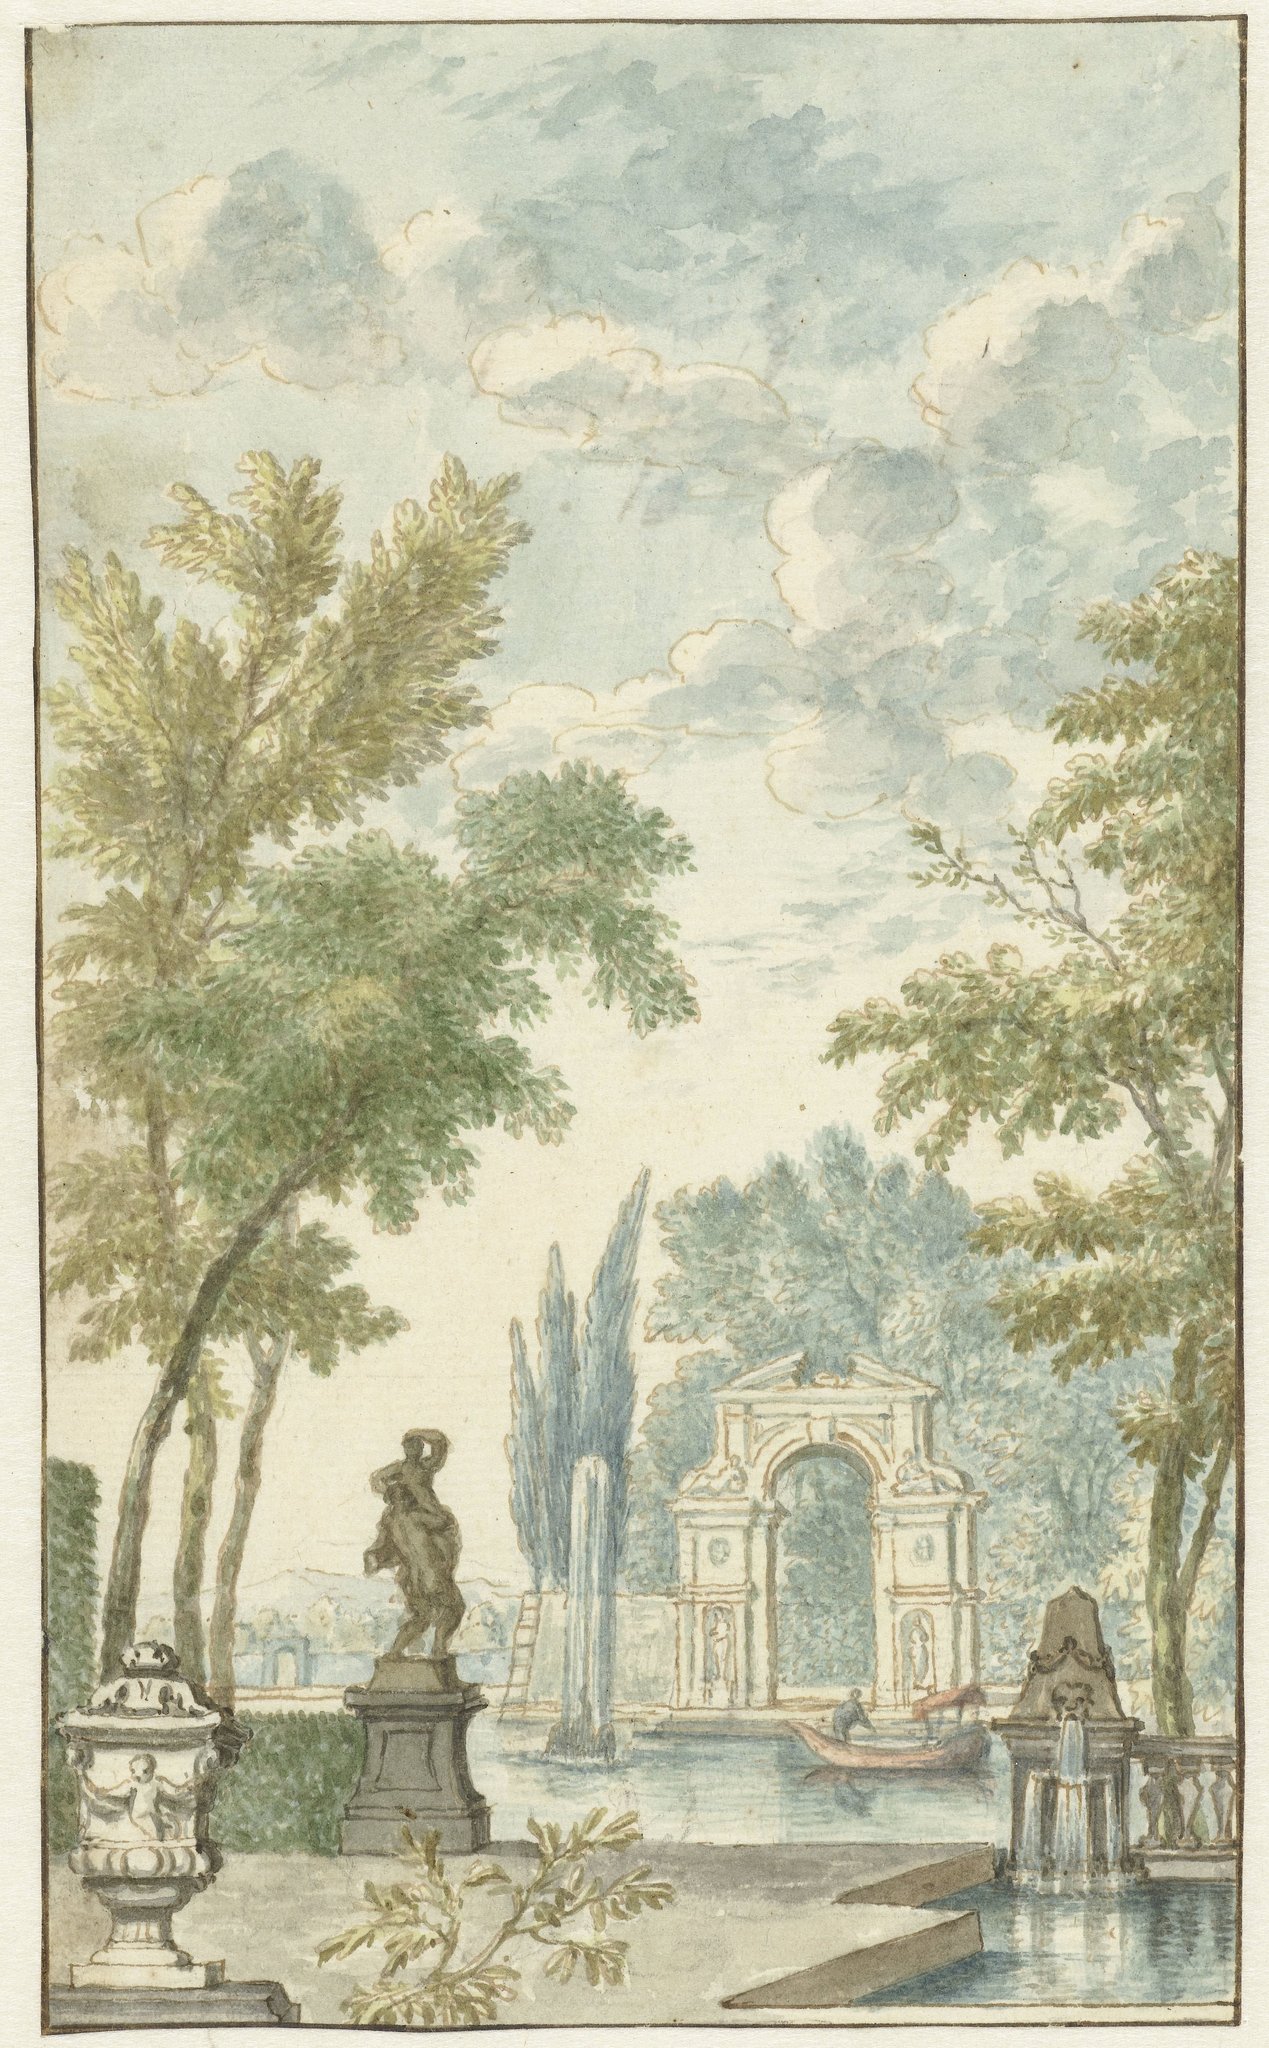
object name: watercolor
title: Tuin met waterpartij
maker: hermanus petrus schouten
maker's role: draughtsman, painter, print maker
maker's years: 1747-1822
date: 1757-1822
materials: ink, paper, watercolor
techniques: brush, pen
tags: garden